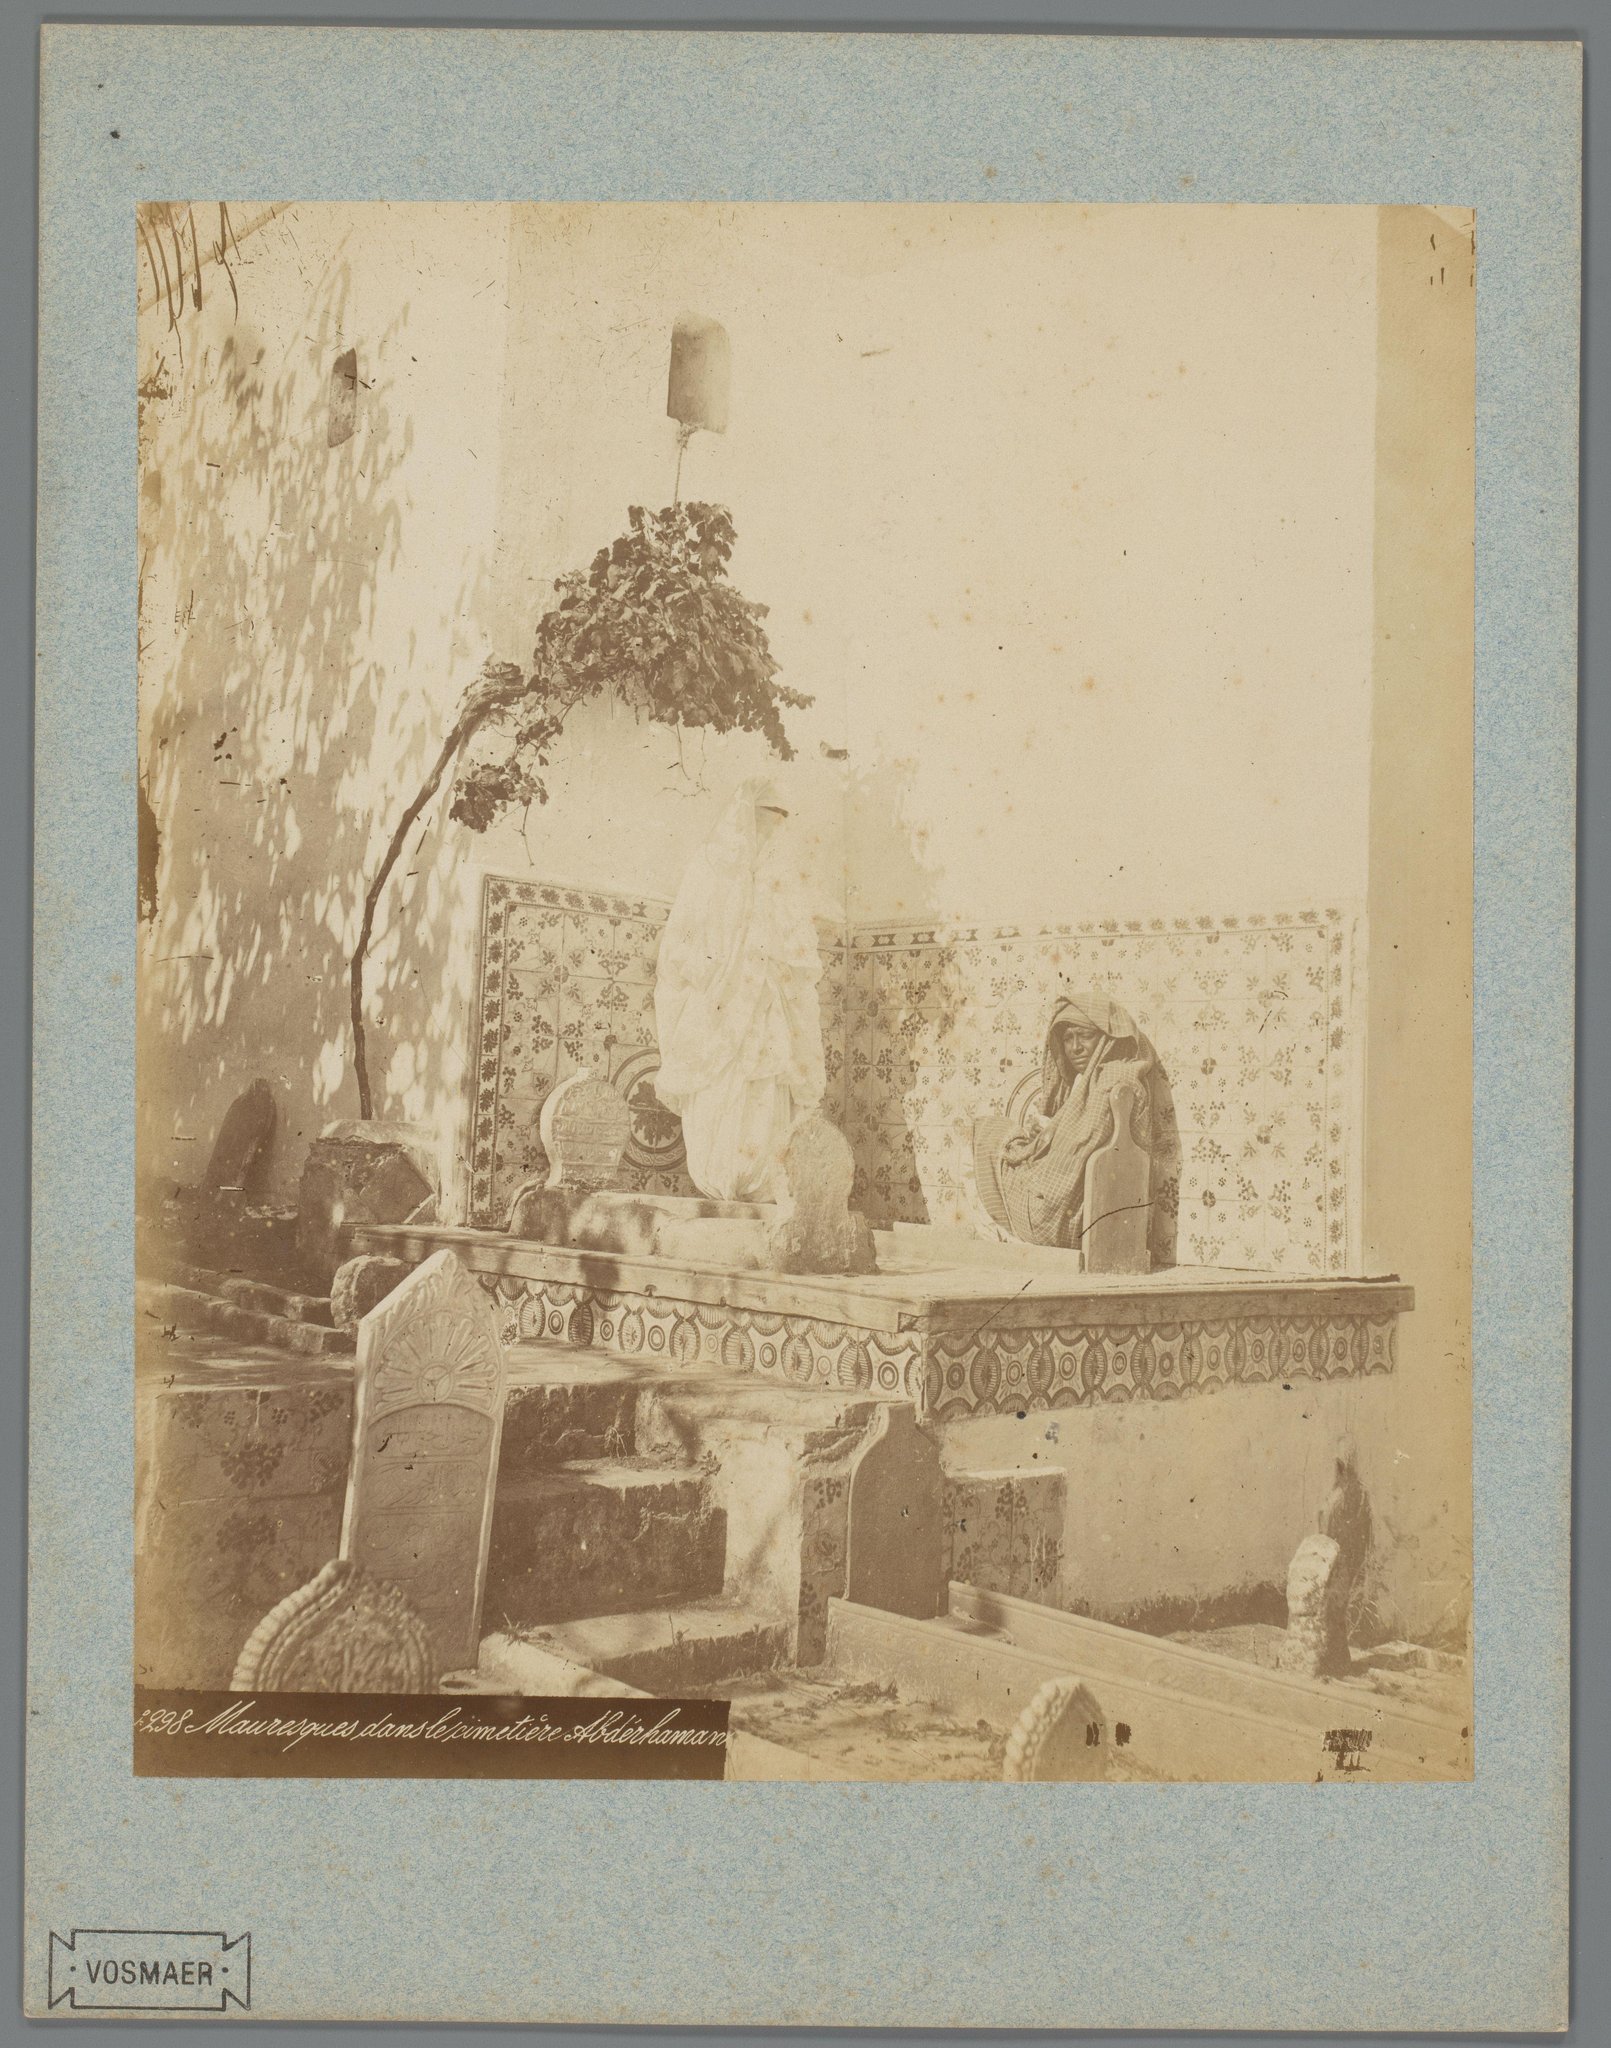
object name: photograph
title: Mauresques dans le cimetiere Abdérhaman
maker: Anonymous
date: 1851-1900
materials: cardboard, paper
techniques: albumen print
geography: algiers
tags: temple, shrine ~ islam, mohammedanism, churchyard, cemetery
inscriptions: collector's mark: ‘VOSMAER’, number: ‘n 298’